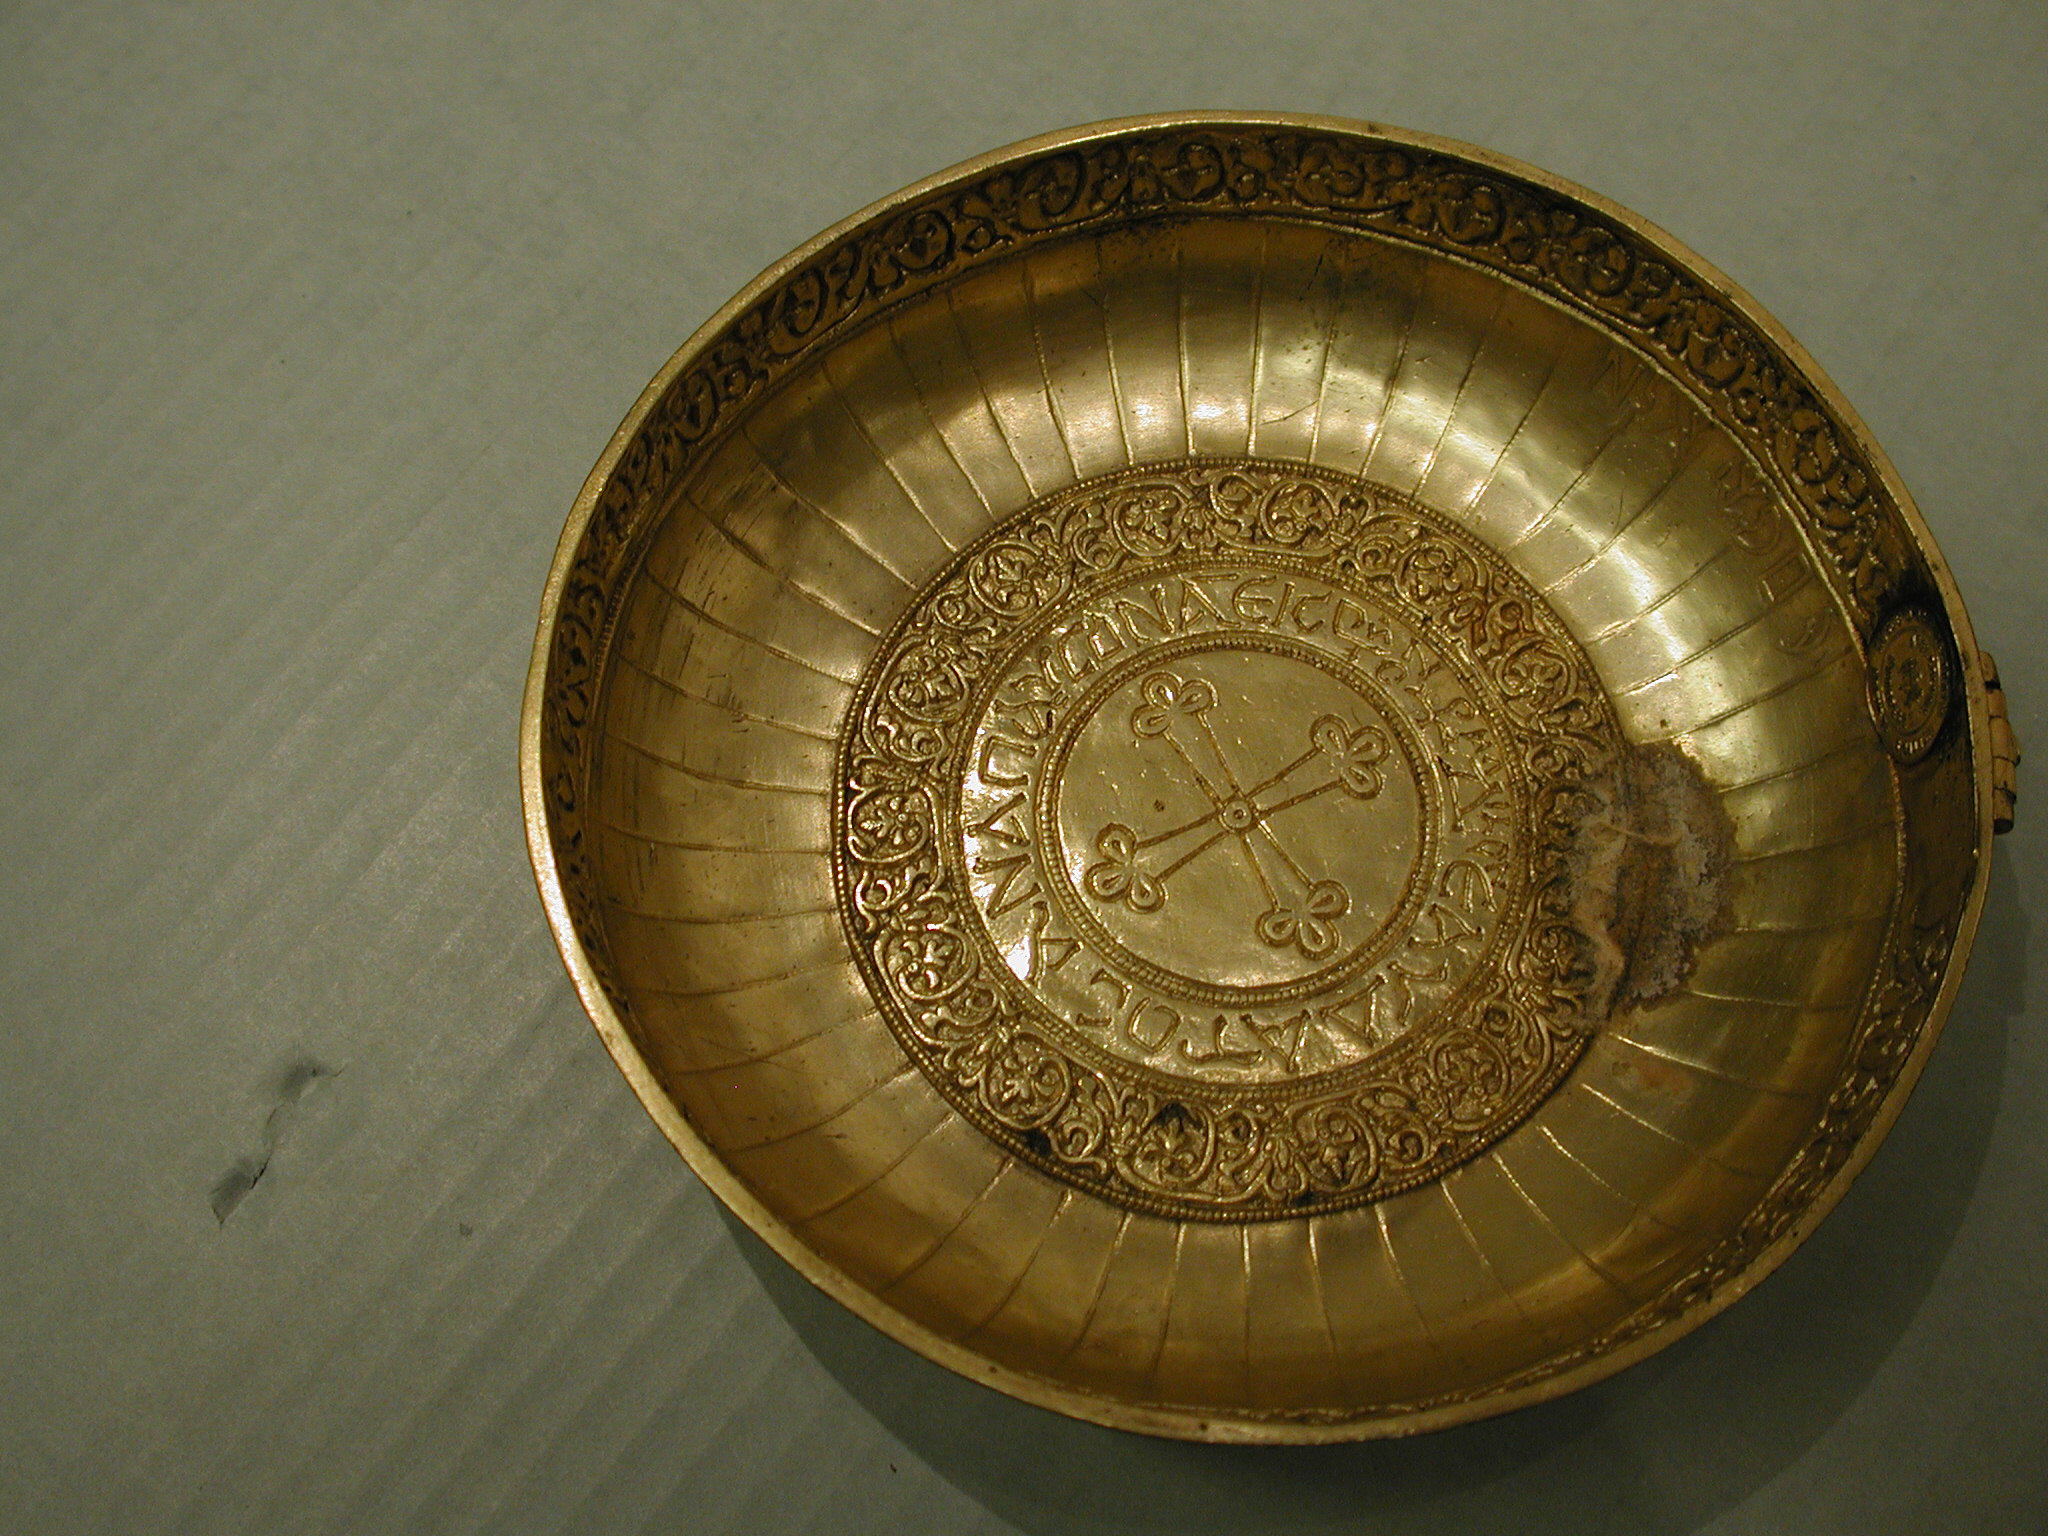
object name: bowl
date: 1801-1900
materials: metal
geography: hungary